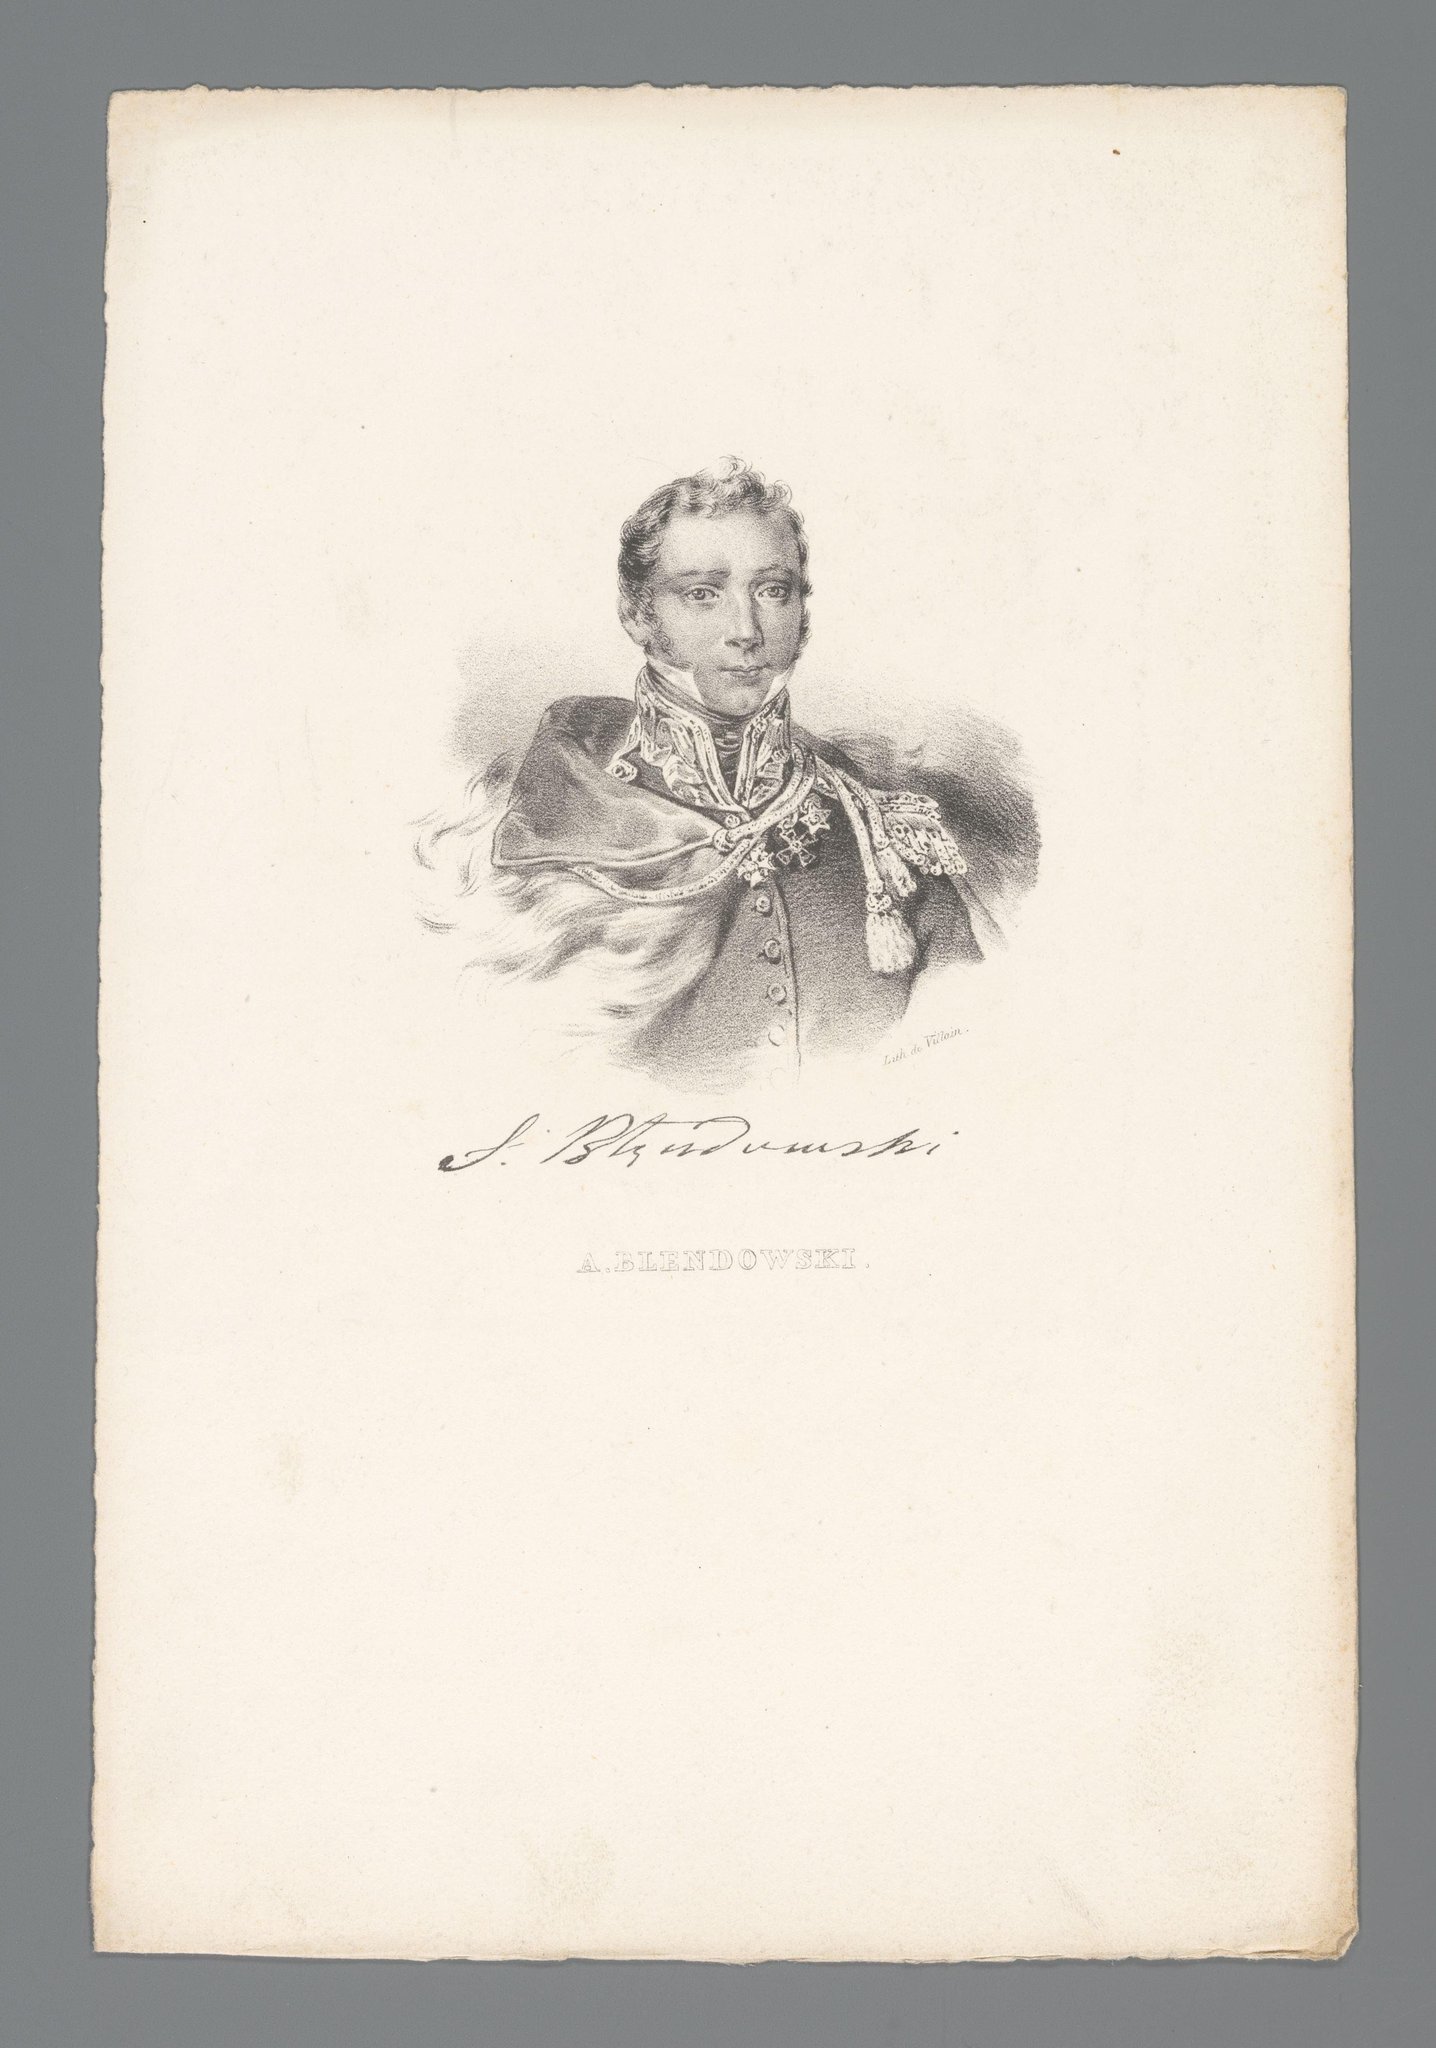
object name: print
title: Portret van Aleksander Blendowski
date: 1832-1839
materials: paper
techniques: lithograph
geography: paris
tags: historical persons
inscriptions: collector's mark: Lugt 2228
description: Prent uit: Straszewicz., Joseph. Les polonais et les polonaises de la révolution du 29 novembre 1830, ou Portraits des personnes qui ont figuré dans la dernière guerre de l'indépendance polonaise, avec les fac-simile de leur signature, lithographiés sur dessins originaux, par les artistes les plus distingués: MM. Grévedon, Maurin, Vigneron, Belliard, Devéria, Bazin, Desmadryl, Lecler, Desmaisons, Rutowski, officier polonais, etc,. etc., accompagnés d'une biographie pour chaque portrait. Parijs: Catherine-Anaïs Pinard, 1832. Of uit: Straszewicz., Joseph. Les polonais et les polonaises de la révolution du 29 novembre 1830. Biographie des personnes qui ont figuré dans la dernière guerre de l'indépendance polonaise, avec les fac-simile de leur signature, ornée de 30 portraits lithographiés sur dessins originaux, par les artistes les plus distingués: MM. Grévedon, Maurin, Vigneron, Belliard, Devéria, Bazin, Desmadryl, Lecler, etc., etc.. Parijs: s.n., 1839.